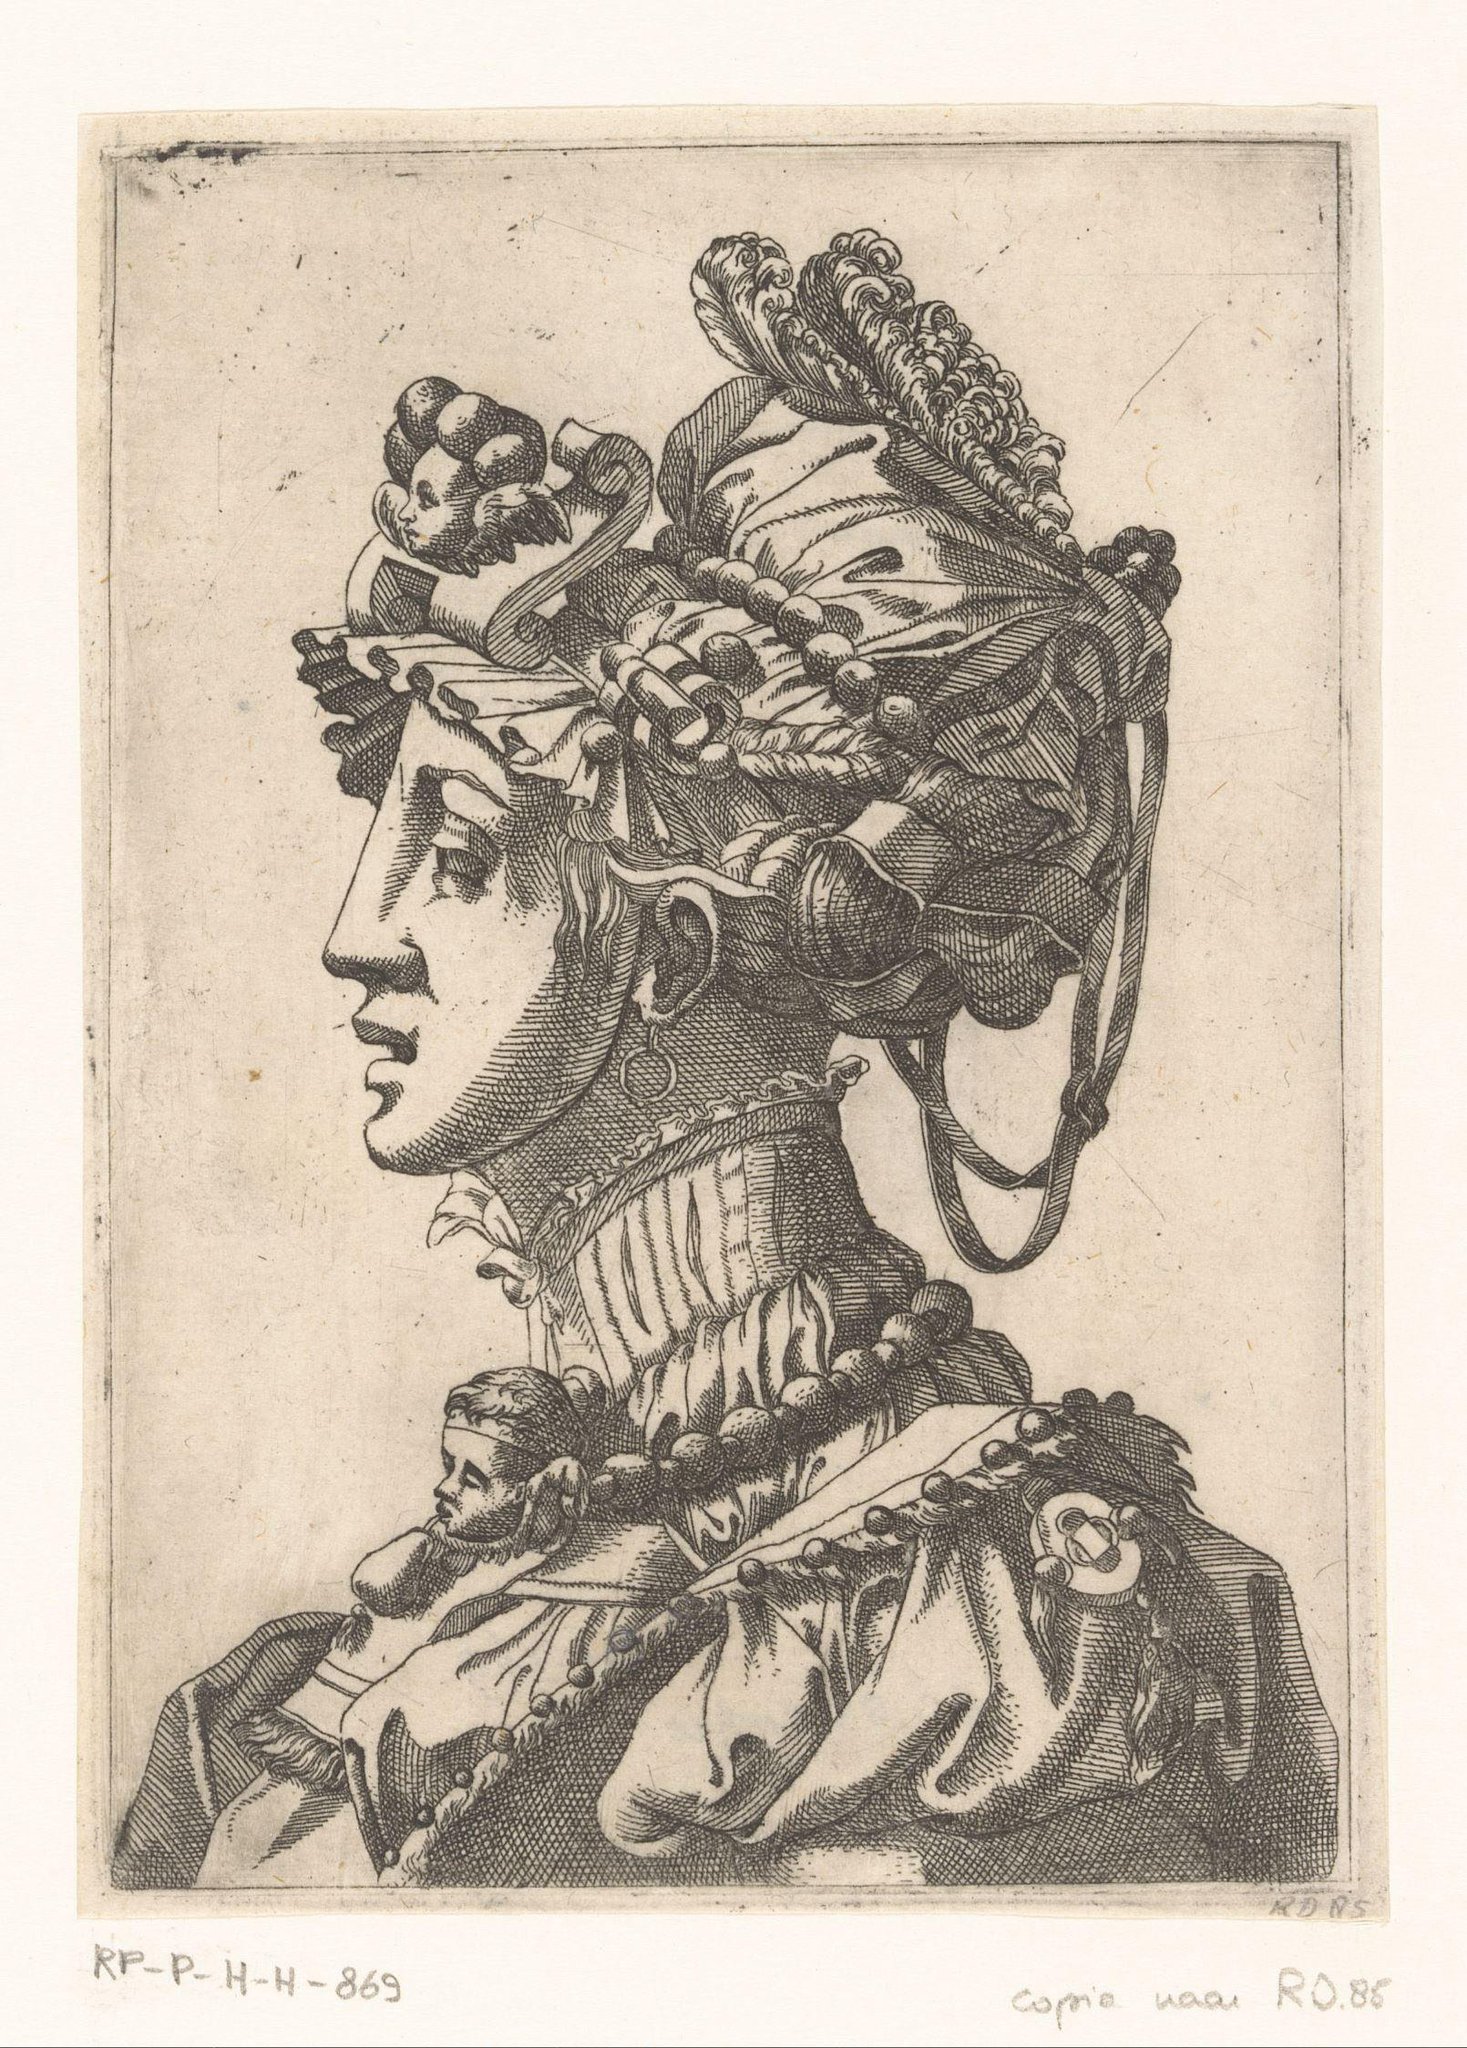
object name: print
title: Vrouw met masker en fantasie hoofdbedekking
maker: Anonymous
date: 1535-1598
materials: paper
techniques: etching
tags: mask, head-gear, the arts of the stage: ballet, theatre, musical drama, motion picture, fantasy costume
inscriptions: collector's mark: Lugt 11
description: Kopie naar een prent uit een serie van twaalf prenten met mannen- en vrouwenkostuums en haardrachten voor het ballet, getiteld 'Coiffures ou masques d'hommes et de femmes pour des ballets', naar ontwerp door Rosso Fiorentino. Betreft een spiegelbeeldige kopie naar de linkerhelft van Dumesnil 85.